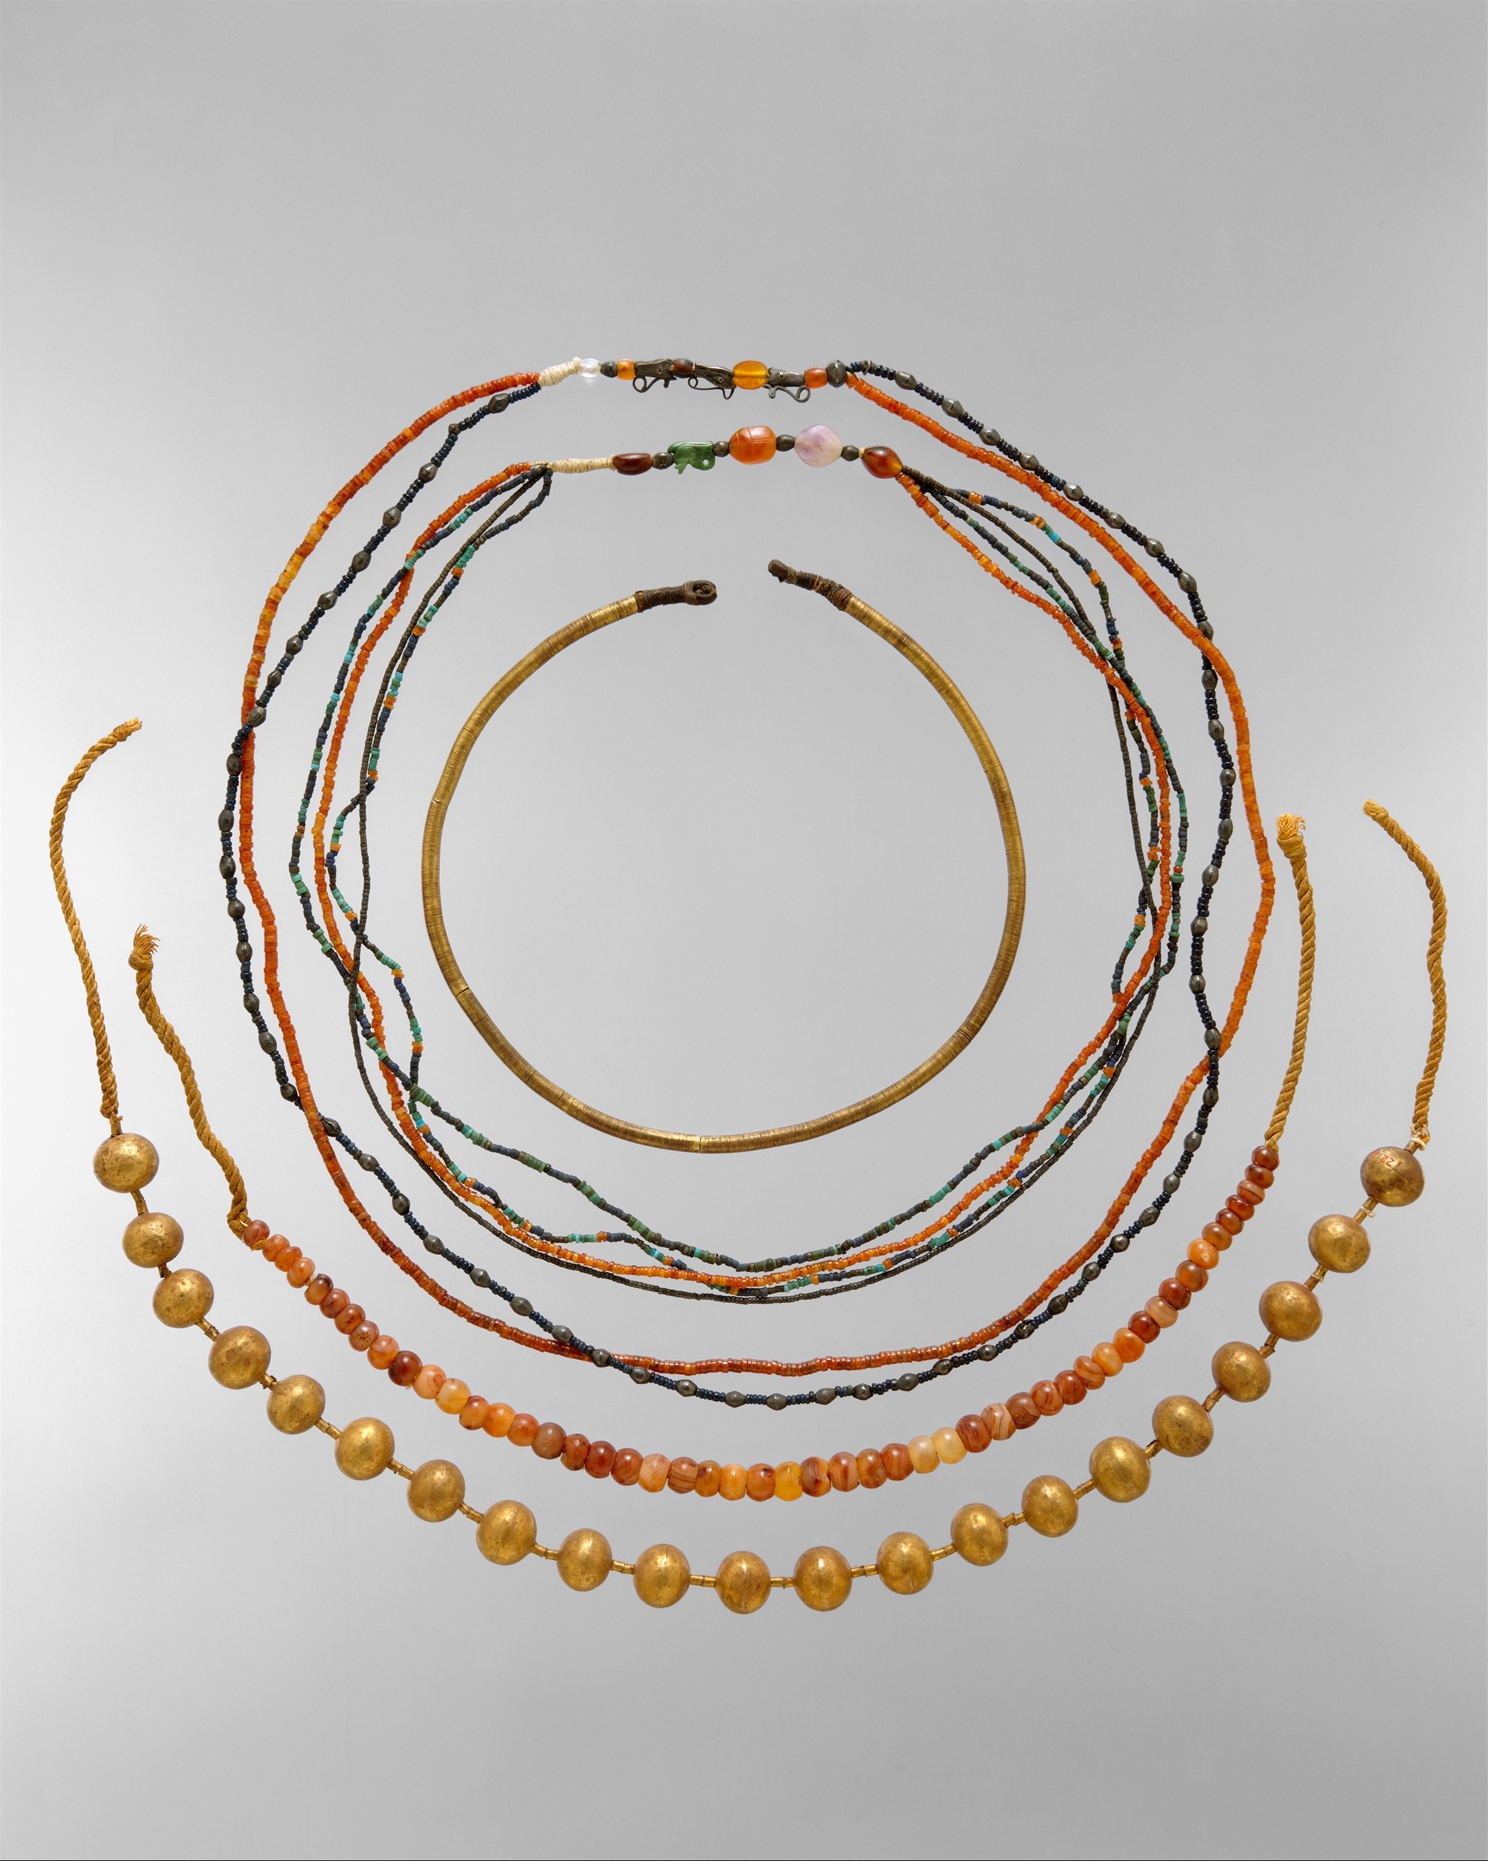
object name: necklace, myt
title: Jewelry of the Child Myt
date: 2051-2030 BCE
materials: gemstone, glass, gold, jasper, leather, linen, paste, quartz, silver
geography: egypt